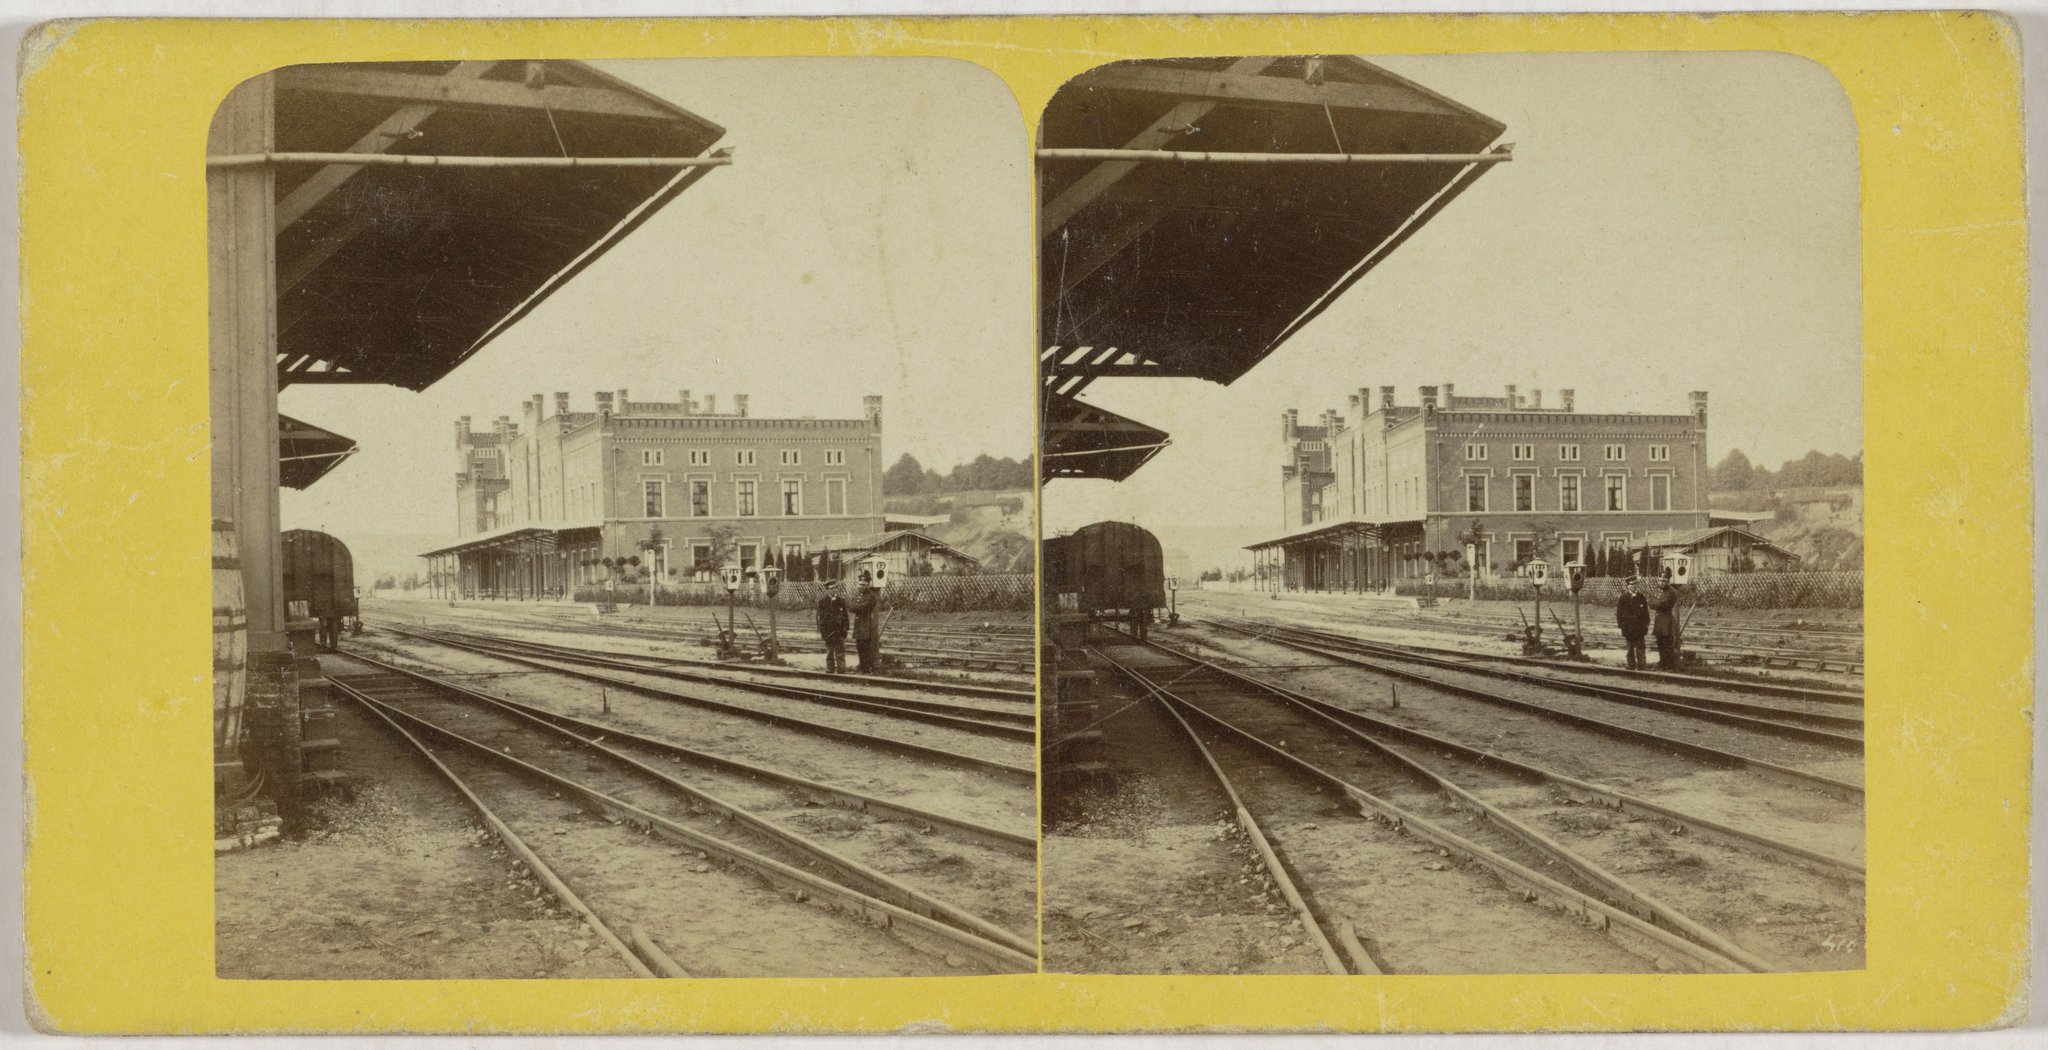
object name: stereograph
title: Gare de Templerbend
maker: t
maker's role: fotograaf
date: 1861-1870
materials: cardboard, paper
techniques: albumen print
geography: aachen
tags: station; shelter (railway, tramway)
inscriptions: number: ‘-478-’, inscription: ‘G’, inscription: ‘9’